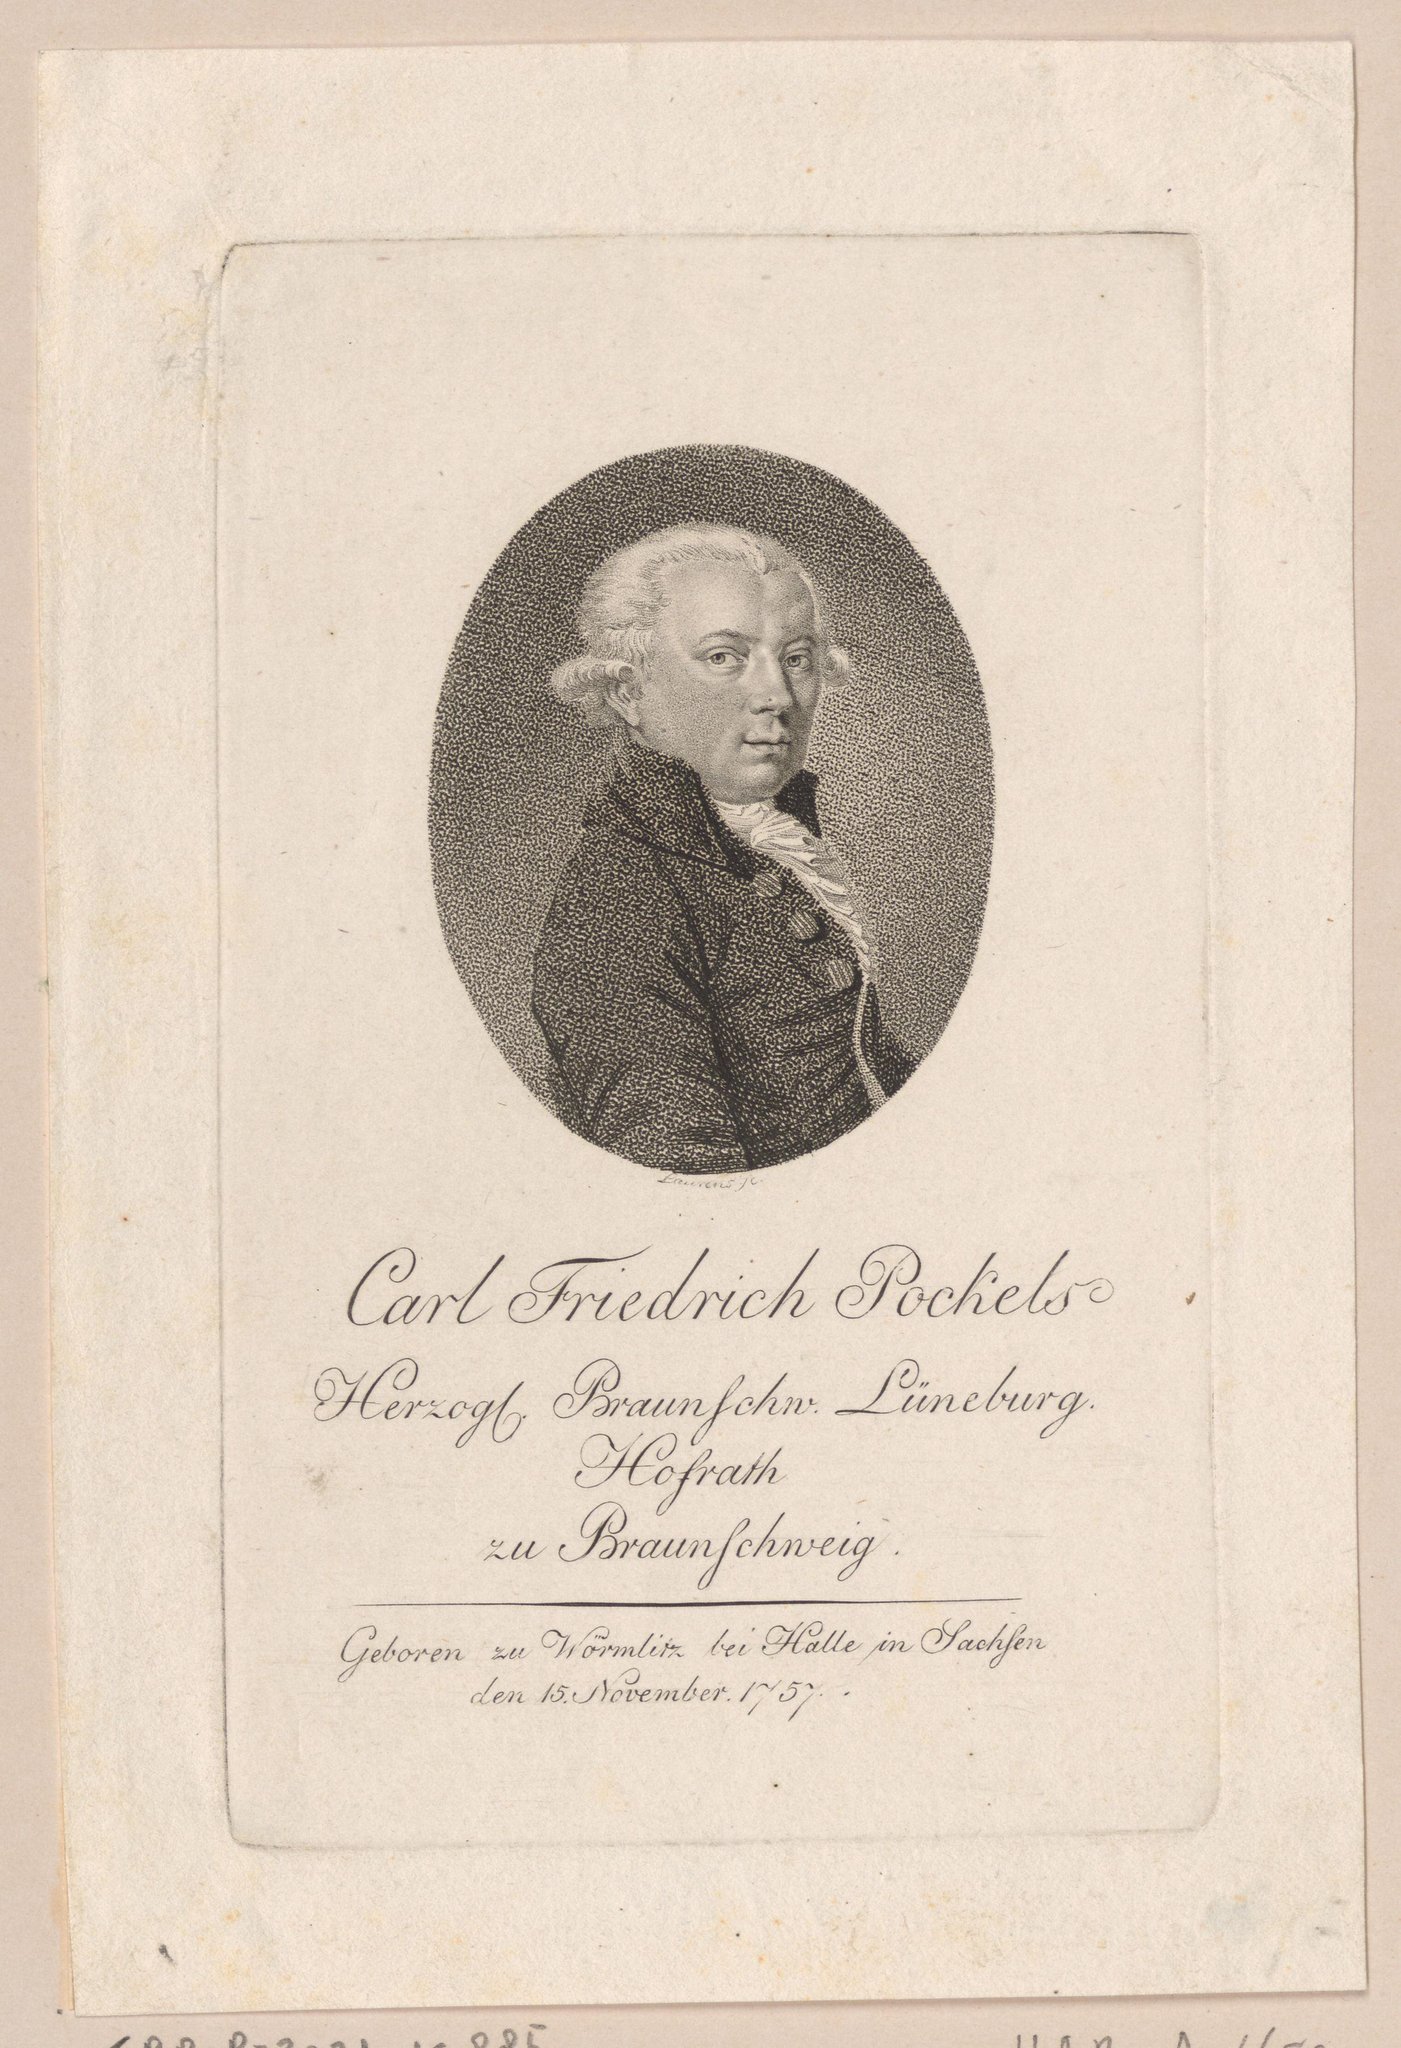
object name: print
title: Portret van Carl Friedrich Pockels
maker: johann daniel laurenz (ii)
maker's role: draughtsman, print maker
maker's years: 1770-1832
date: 1780-1832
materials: paper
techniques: engraving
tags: historical persons, portrait of a writer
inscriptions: collector's mark: Lugt 2228